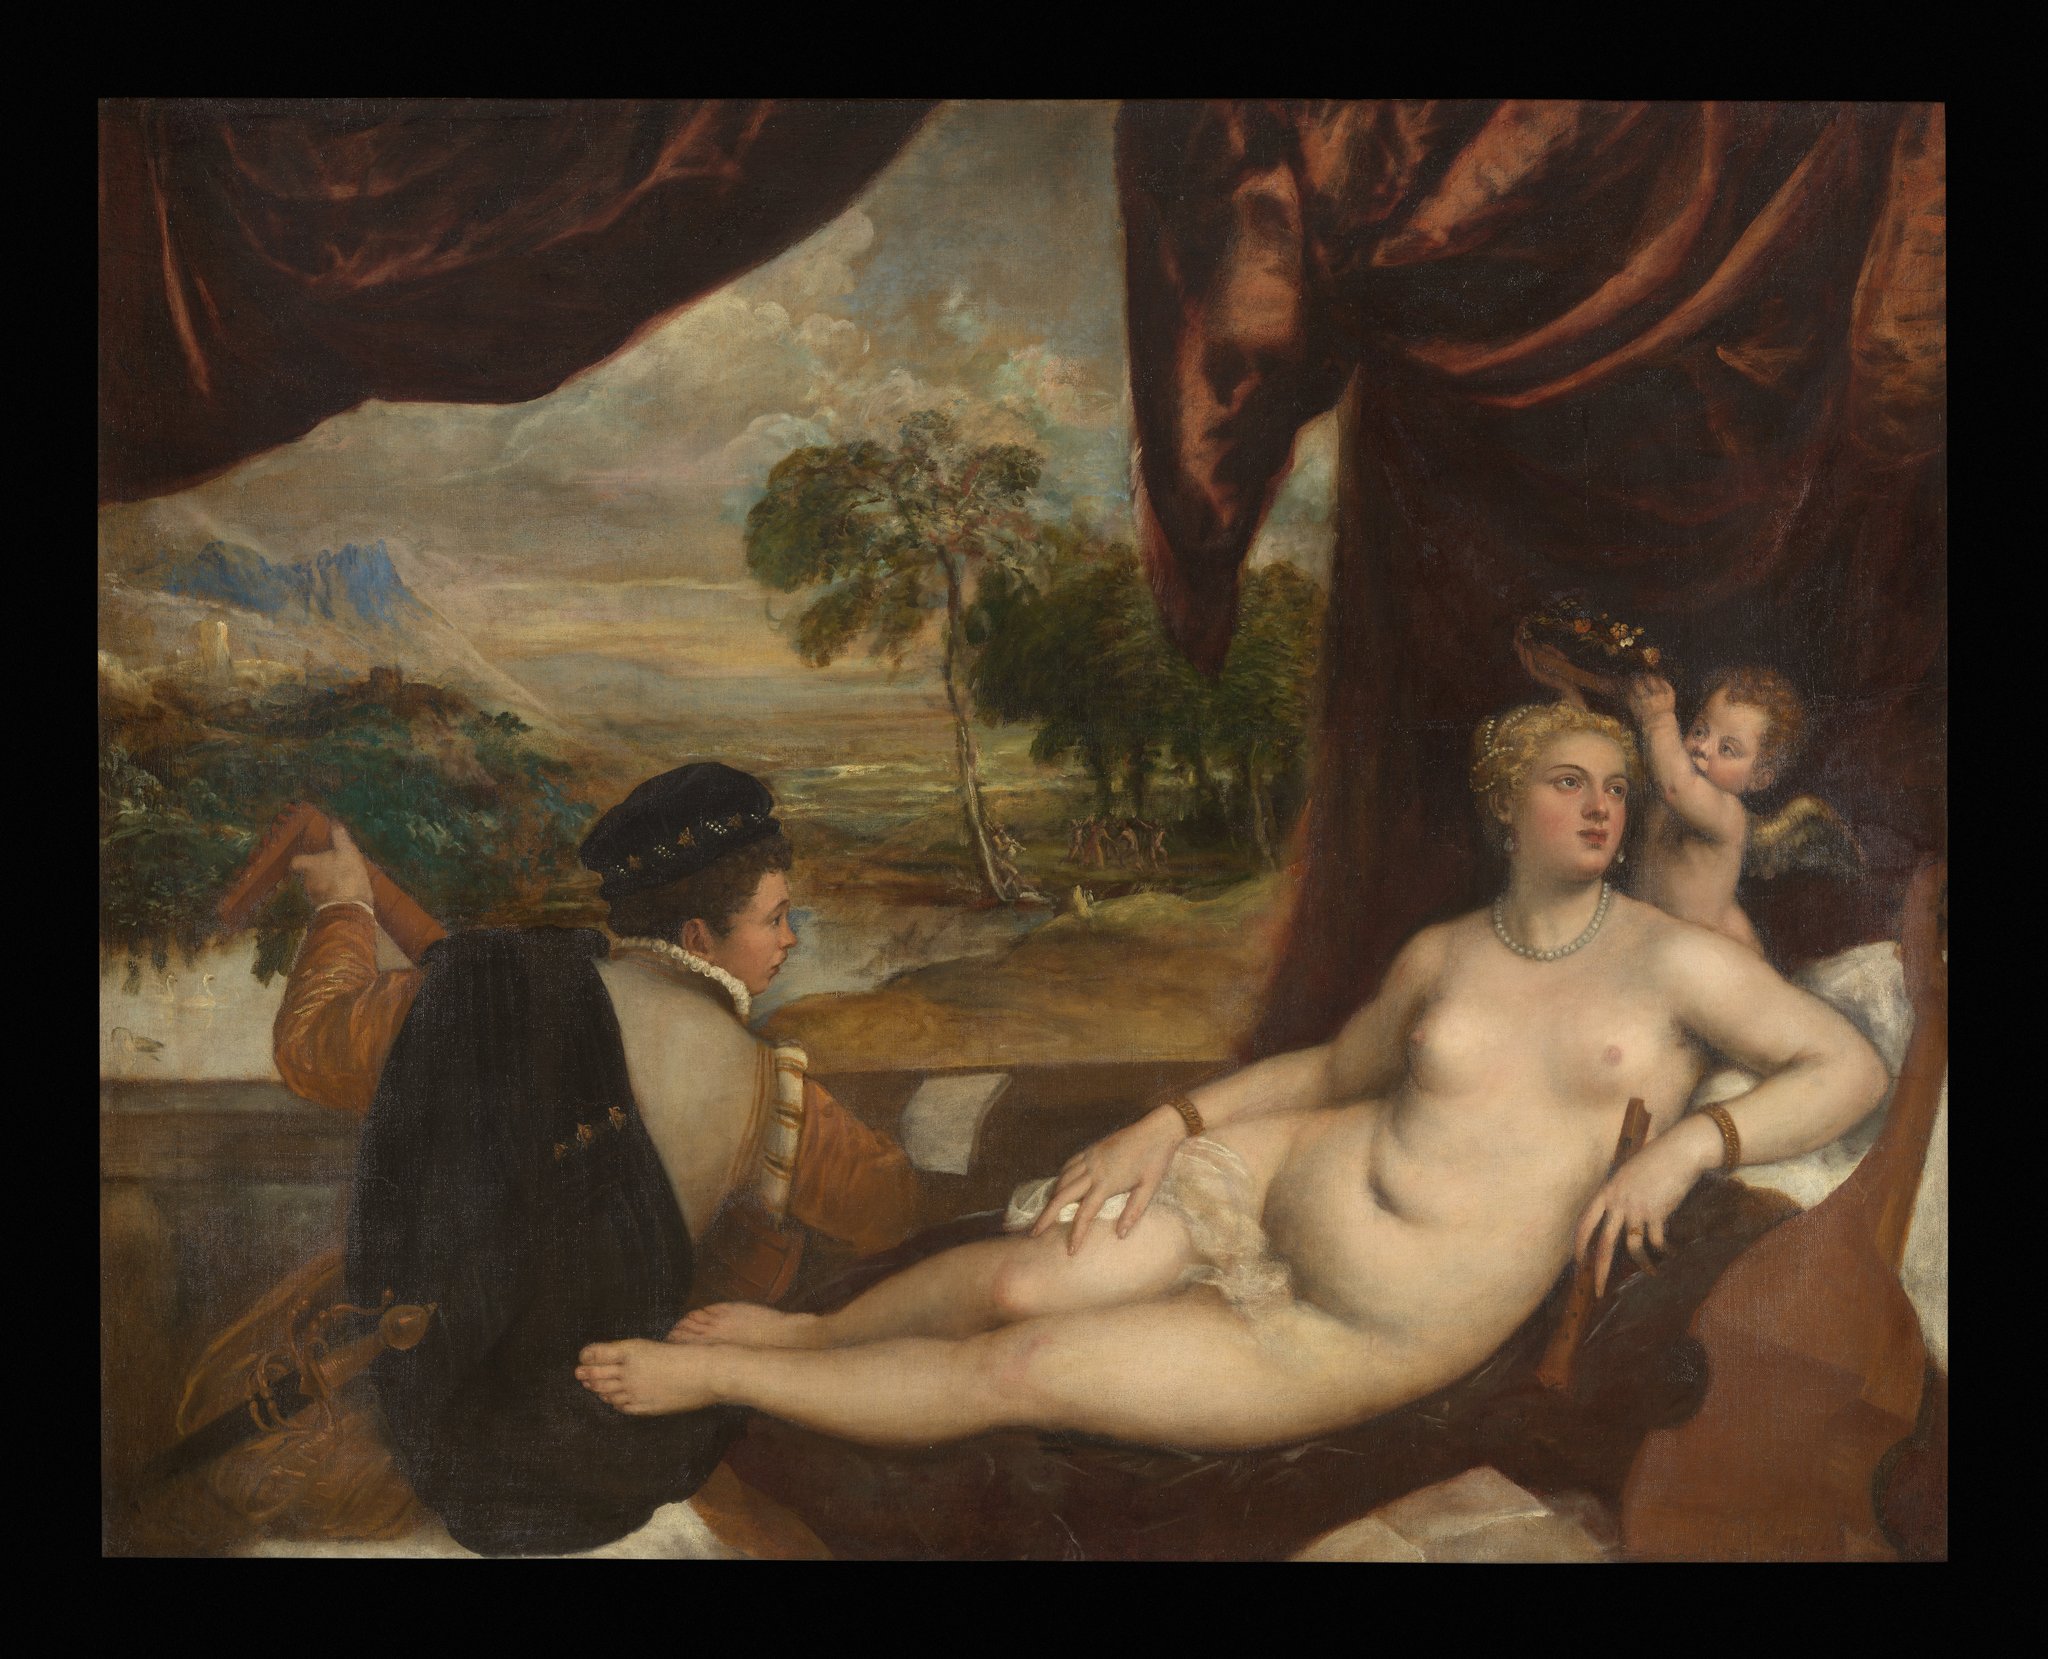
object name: painting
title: Venus and the Lute Player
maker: titian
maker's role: artist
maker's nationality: italian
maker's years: 1485-1576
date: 1565-1570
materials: canvas, oil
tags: female nudes,lutes,cupid,venus,musicians